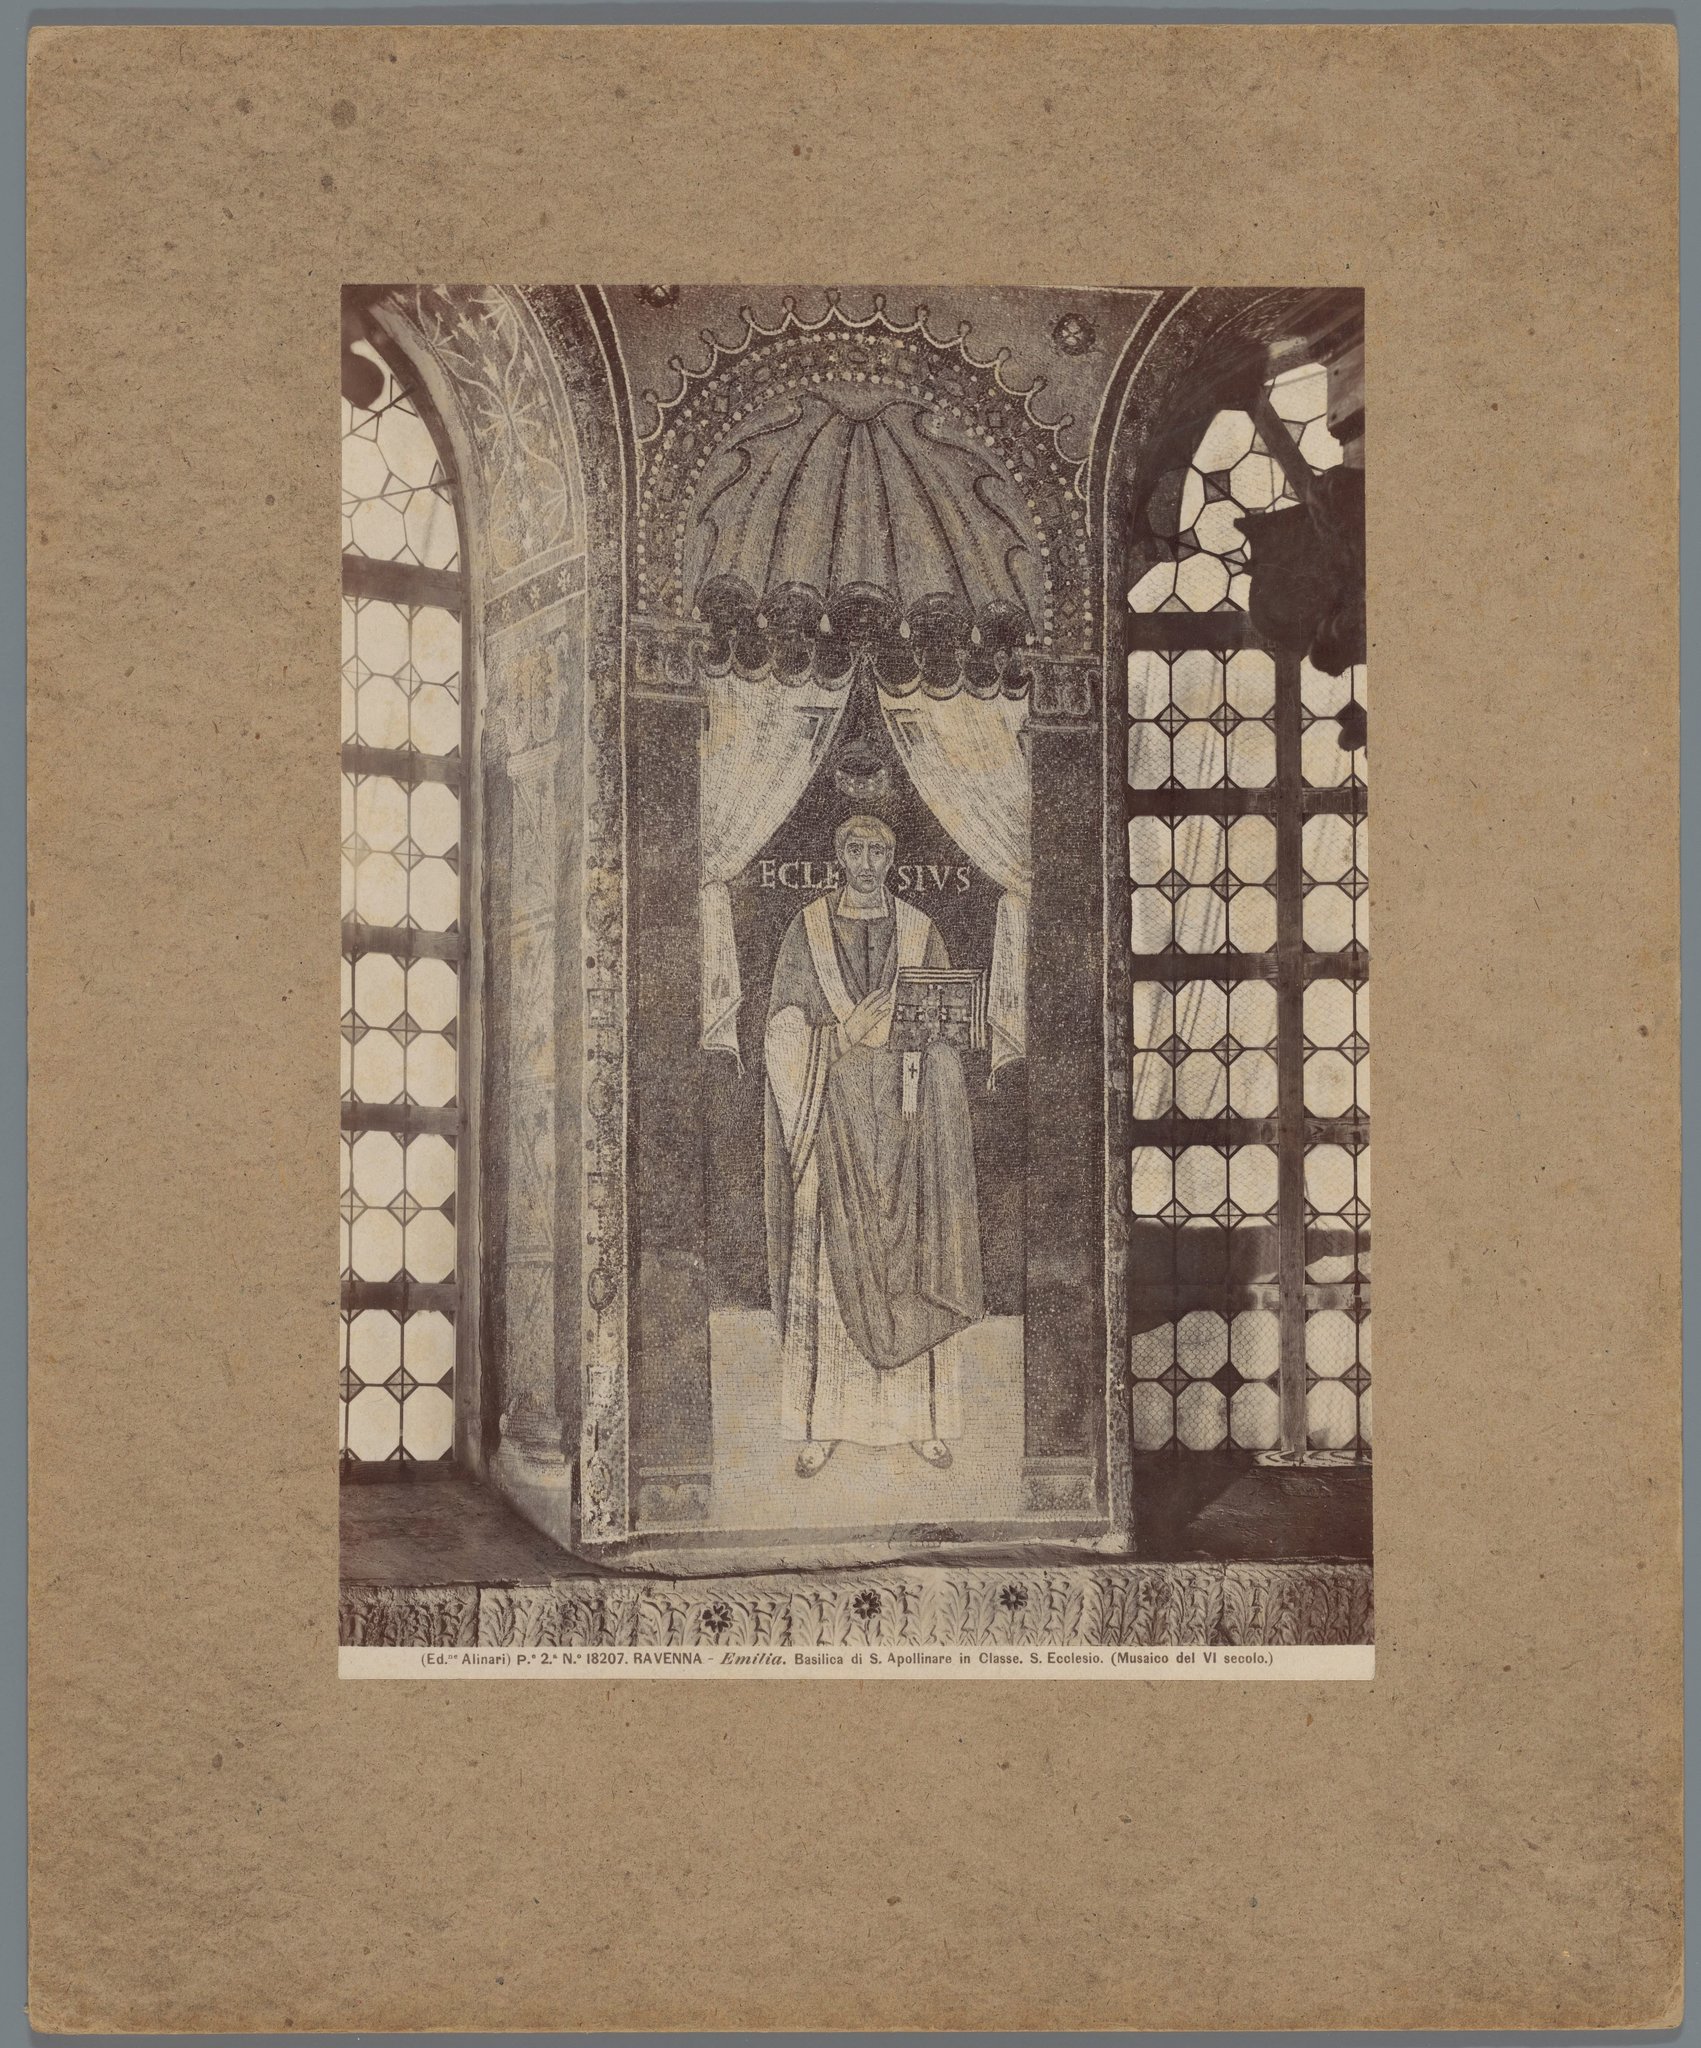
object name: photograph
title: Mozaïek in de Basiliek van Sant'Apollinare in Classe te Ravenna, voorstellende de heilige Ecclesius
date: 1875-1900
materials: cardboard, photographic support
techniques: albumen print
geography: basiliek van sant'apollinare in classe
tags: art (+ mosaic making), saints, interior of church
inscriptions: number: ‘P.e 2.a N.o 18207.’, collector's mark: Lugt 3937